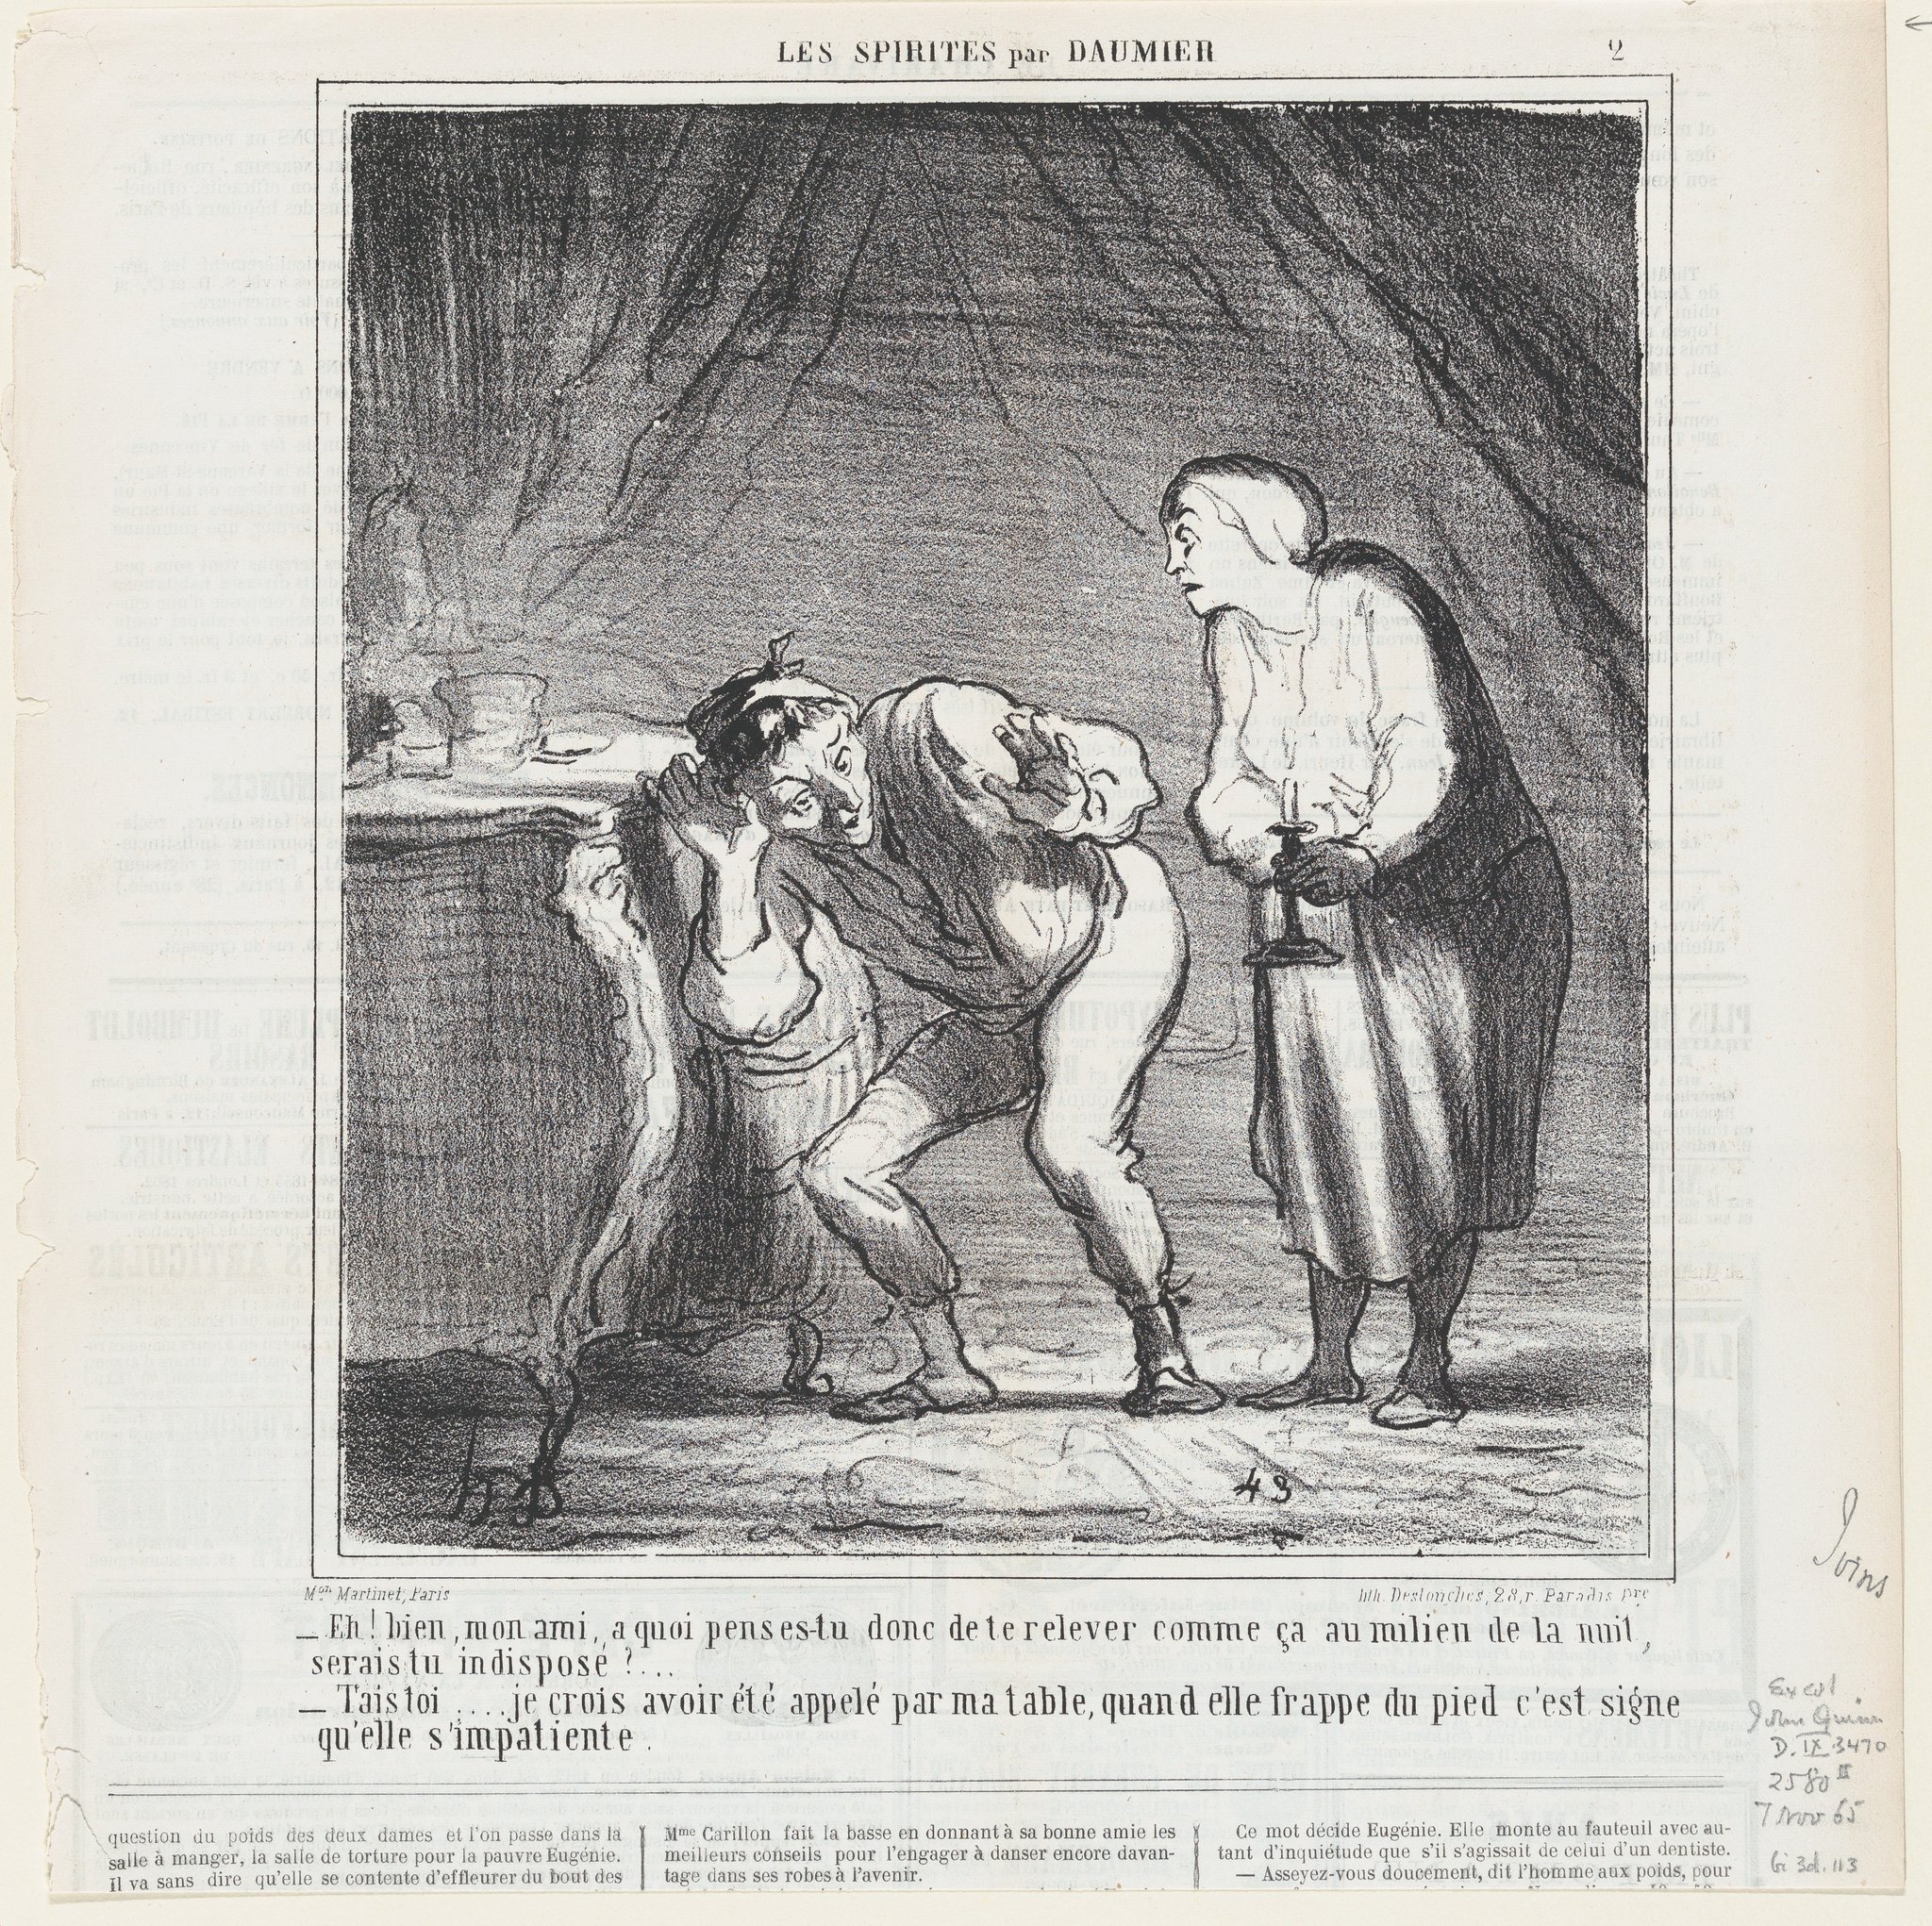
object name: print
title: My friend, why are you up in the middle of the night, are you ill?, from 'The spiritualists,' published in Le Charivari, November 7, 1865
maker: honoré daumier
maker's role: artist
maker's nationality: french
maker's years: 1808-1879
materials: paper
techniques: lithograph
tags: men,women